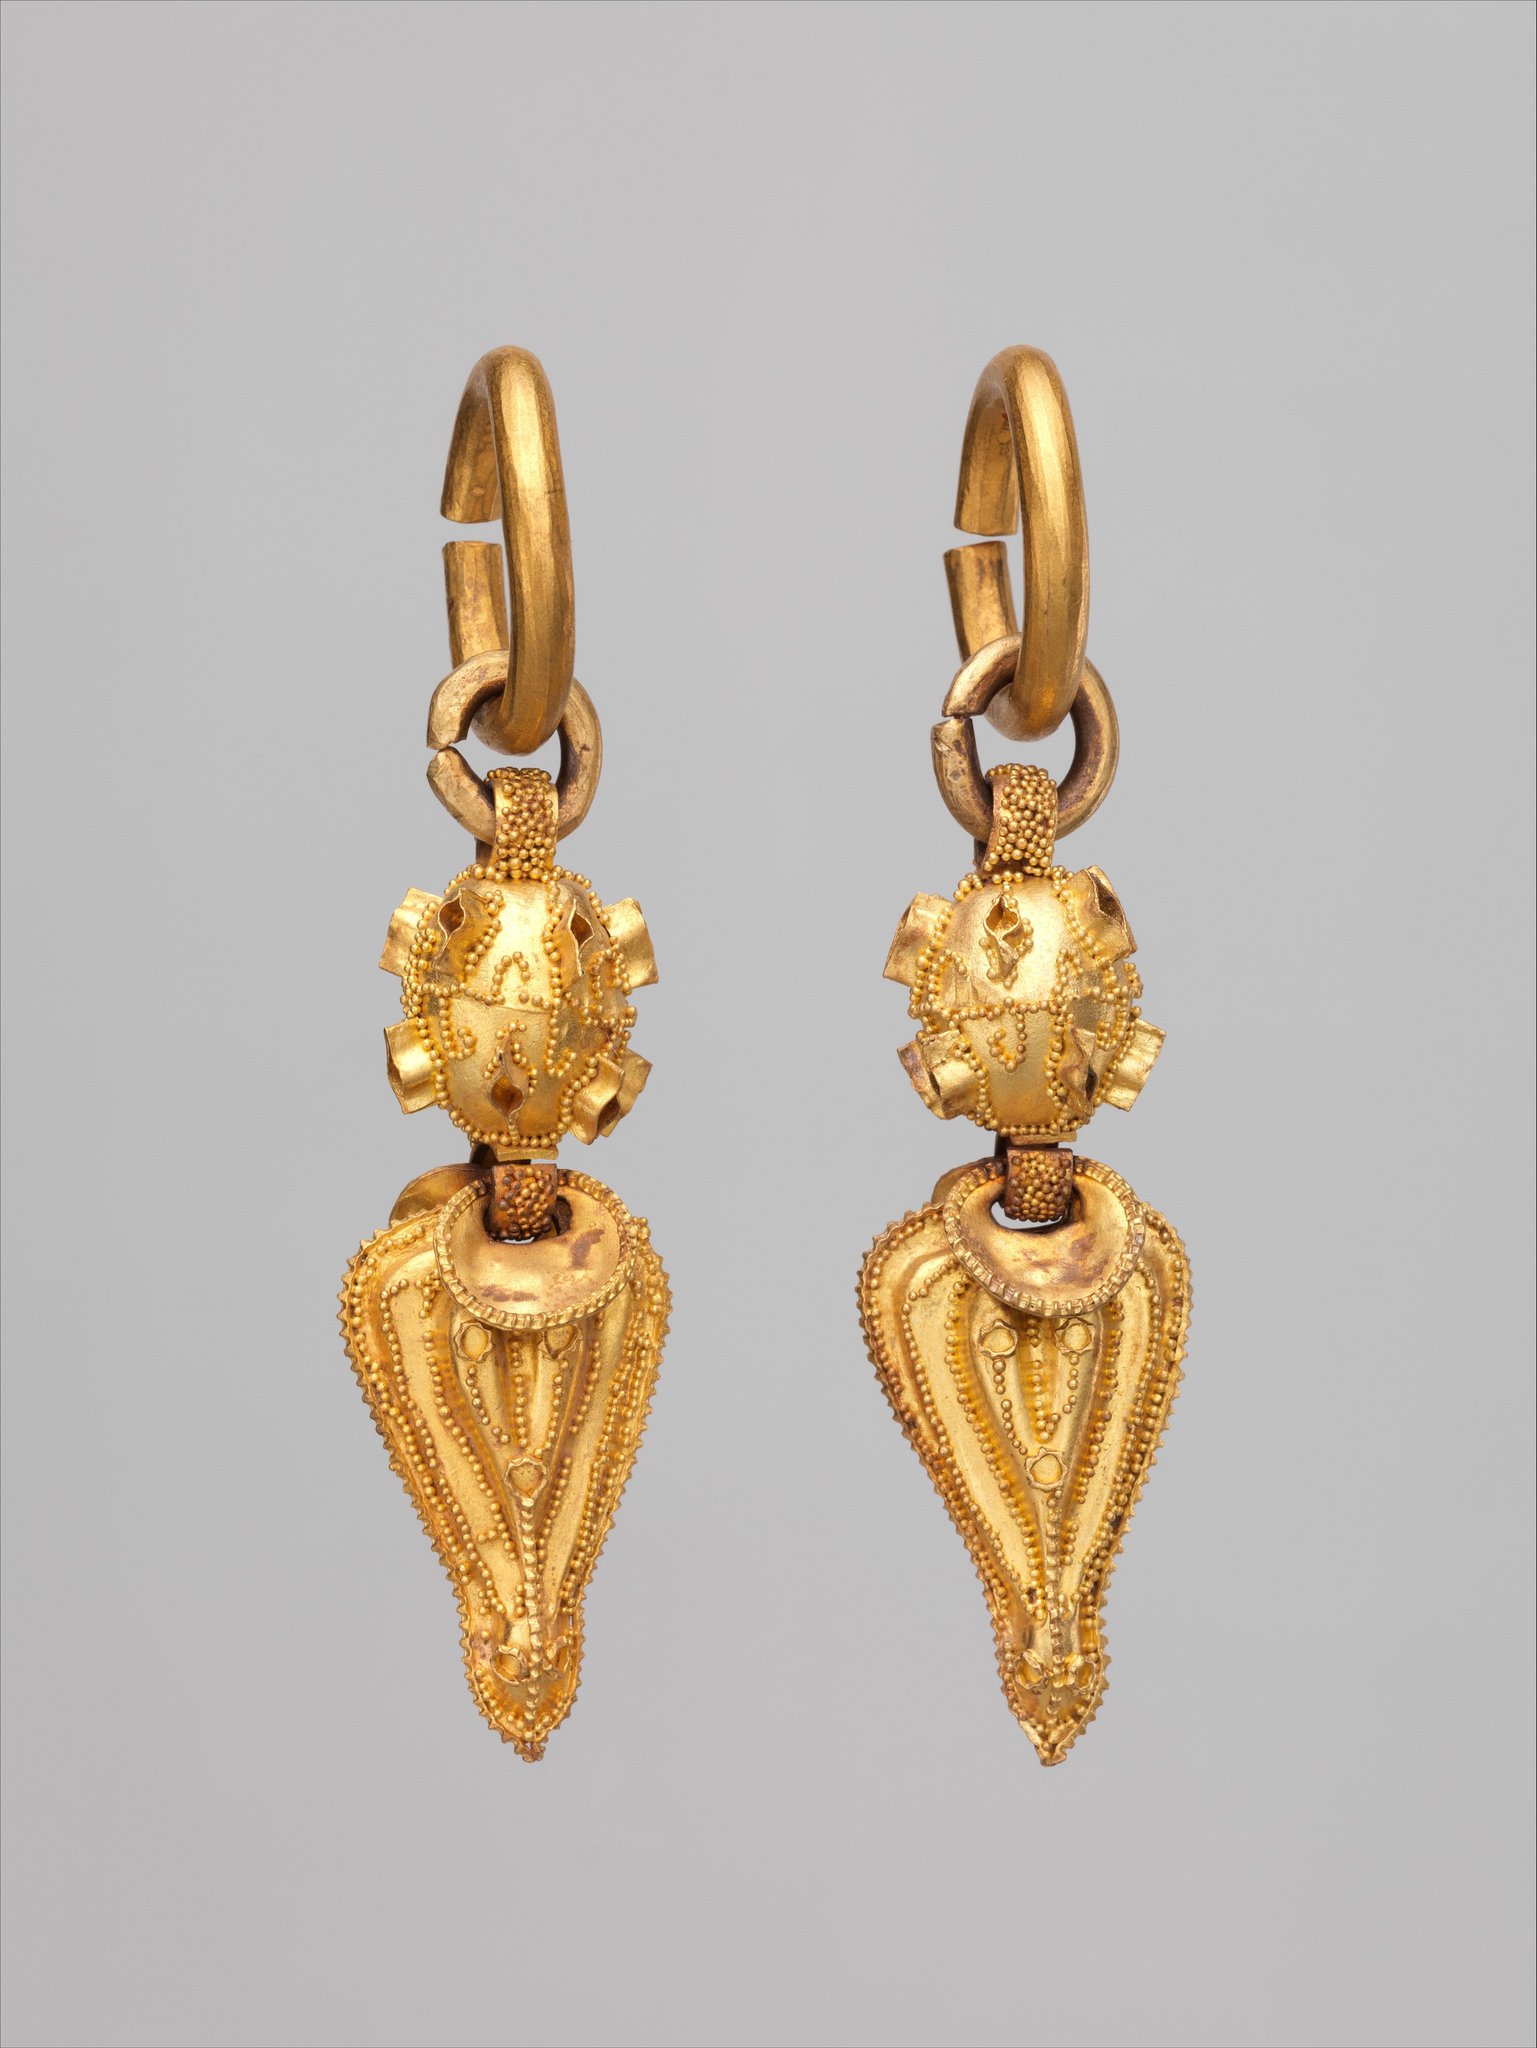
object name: earring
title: Earring (one of a pair)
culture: korean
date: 401-500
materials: gold